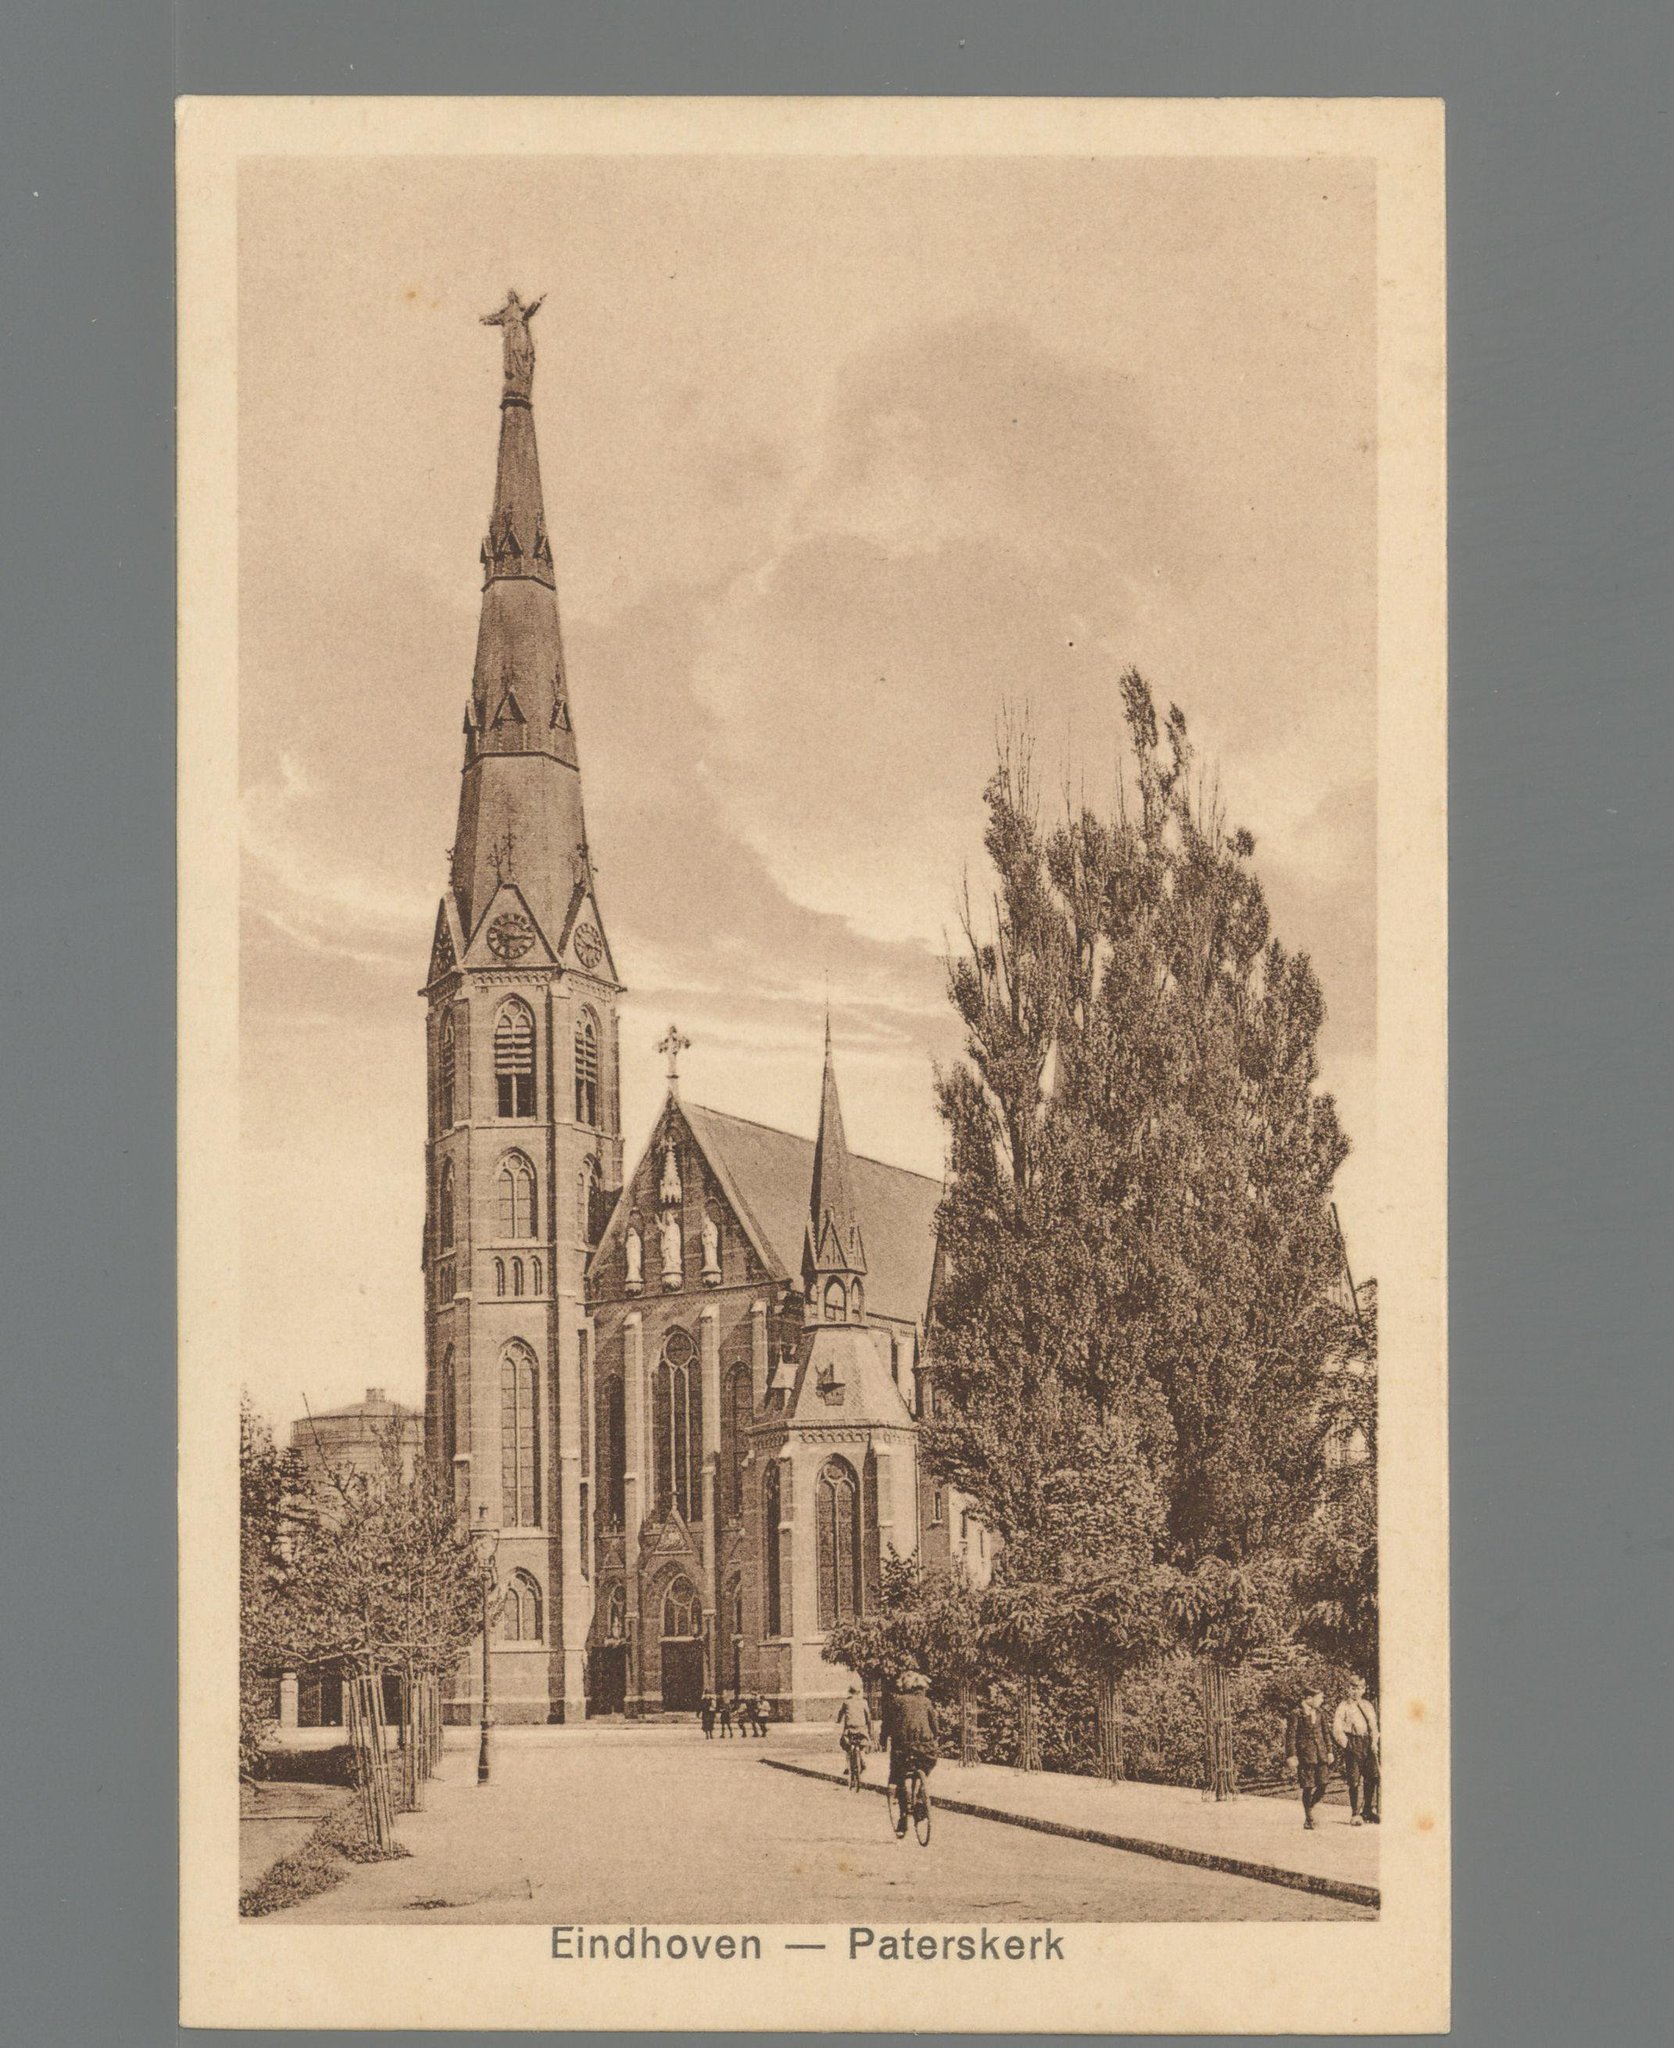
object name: ansichtkaart, prentbriefkaart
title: Eindhoven - Paterskerk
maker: Anonymous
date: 1923-1950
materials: cardboard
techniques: photograph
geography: baarn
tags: church (exterior)